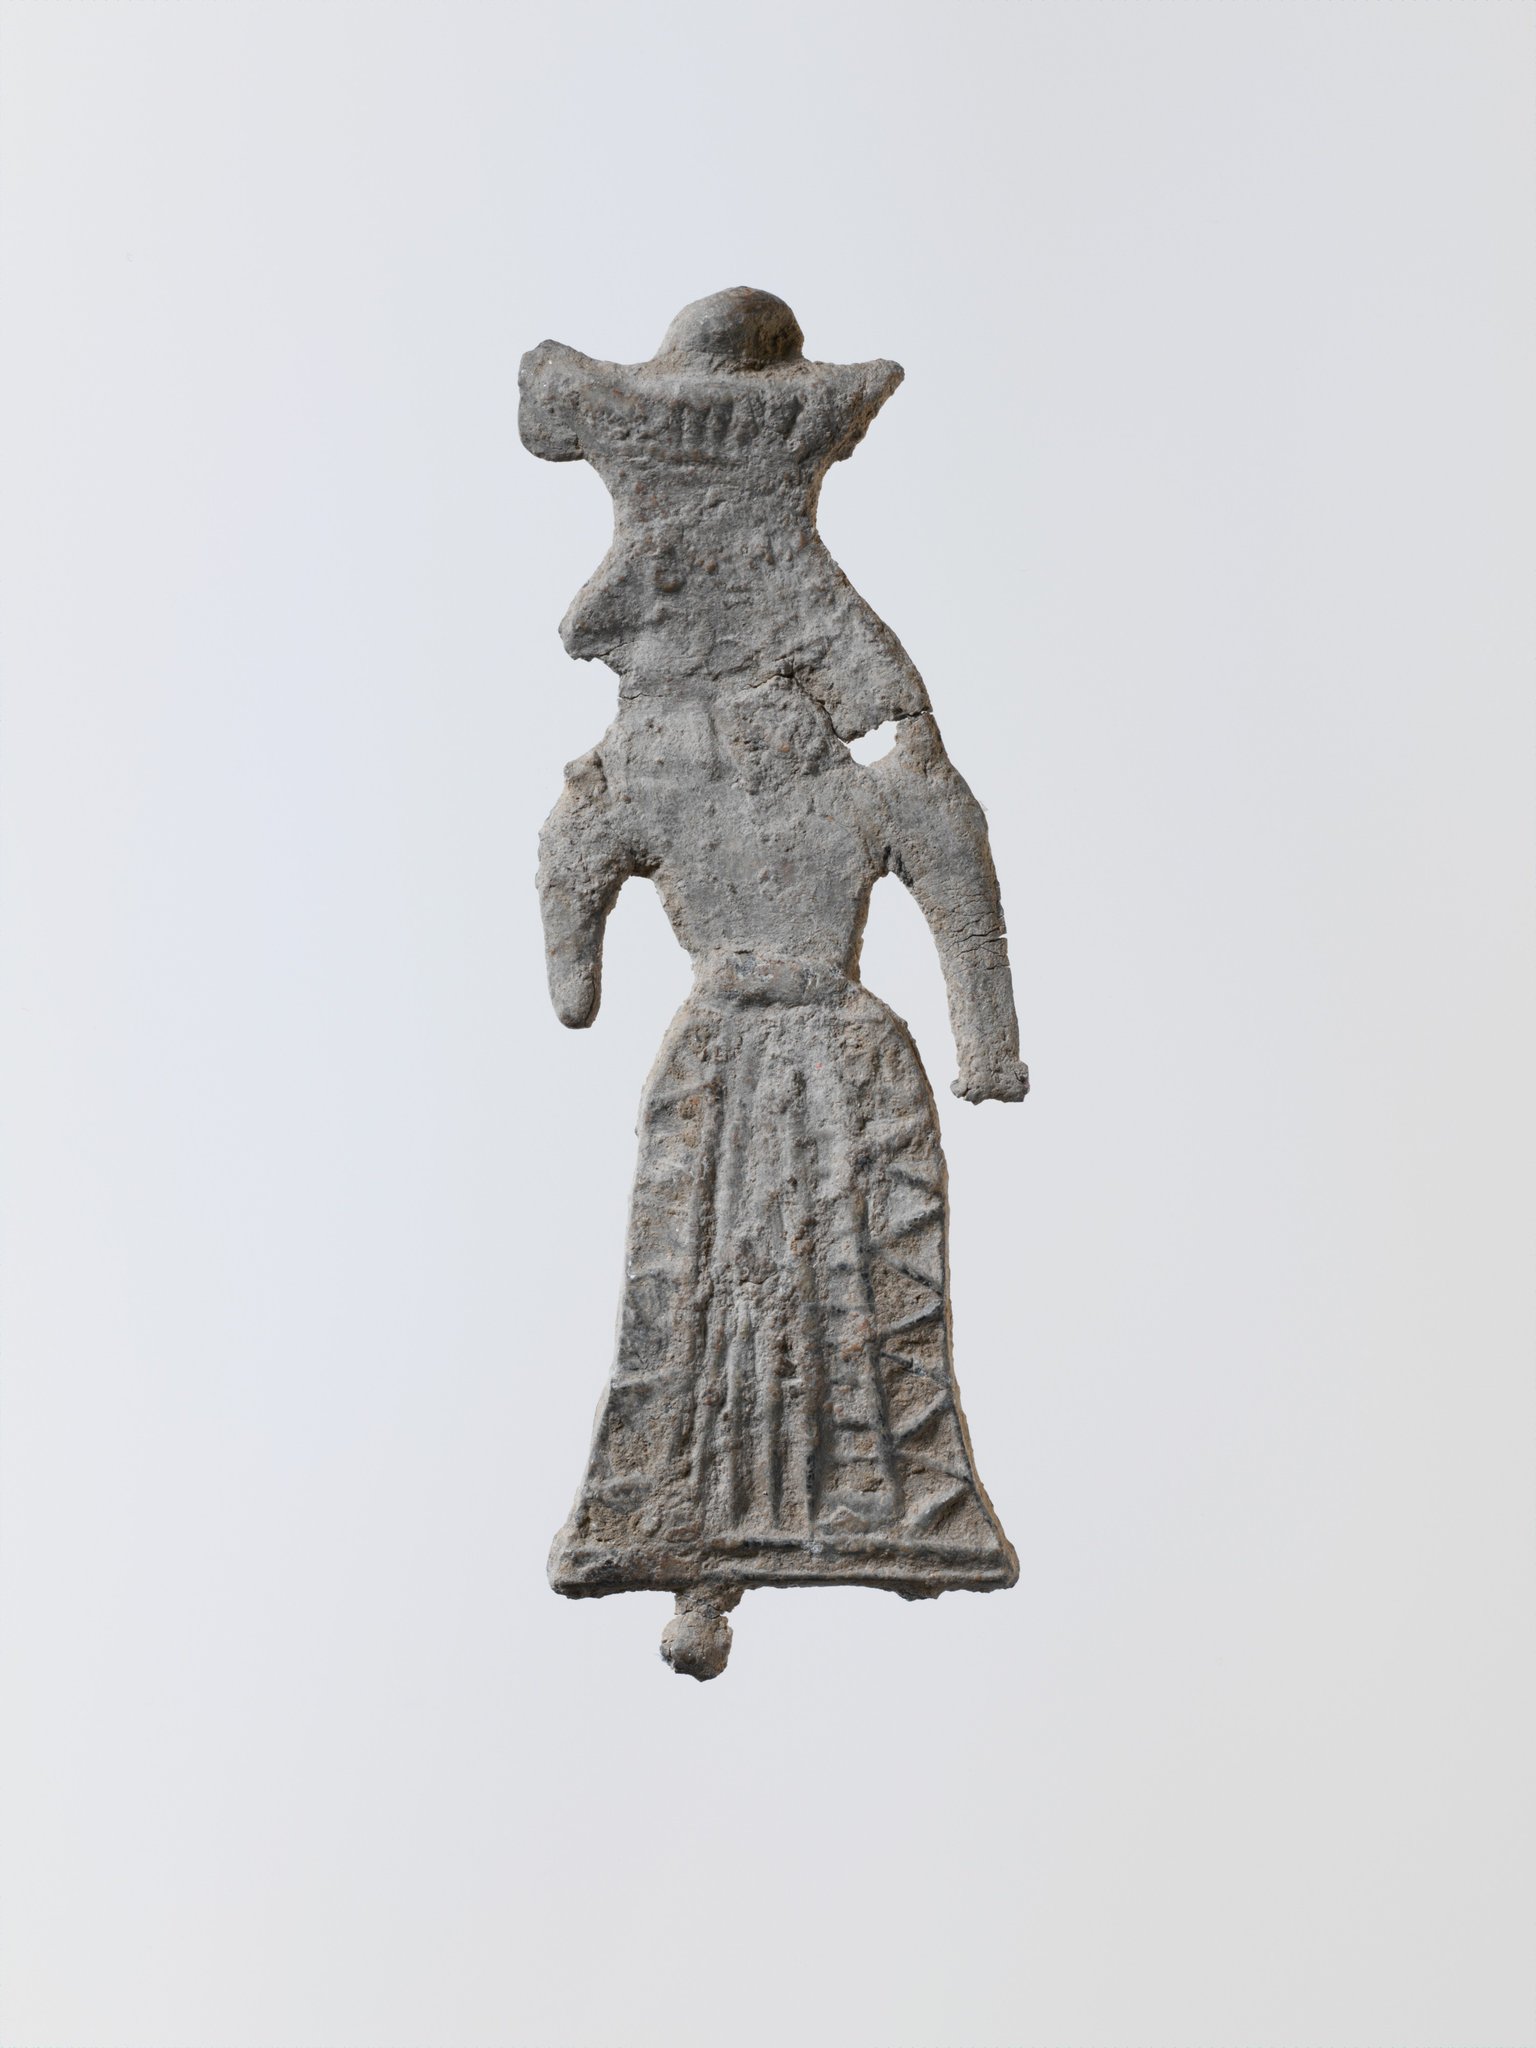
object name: statuette of a woman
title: Lead figure of a woman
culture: greek, laconian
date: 667-568 BCE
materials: lead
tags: women